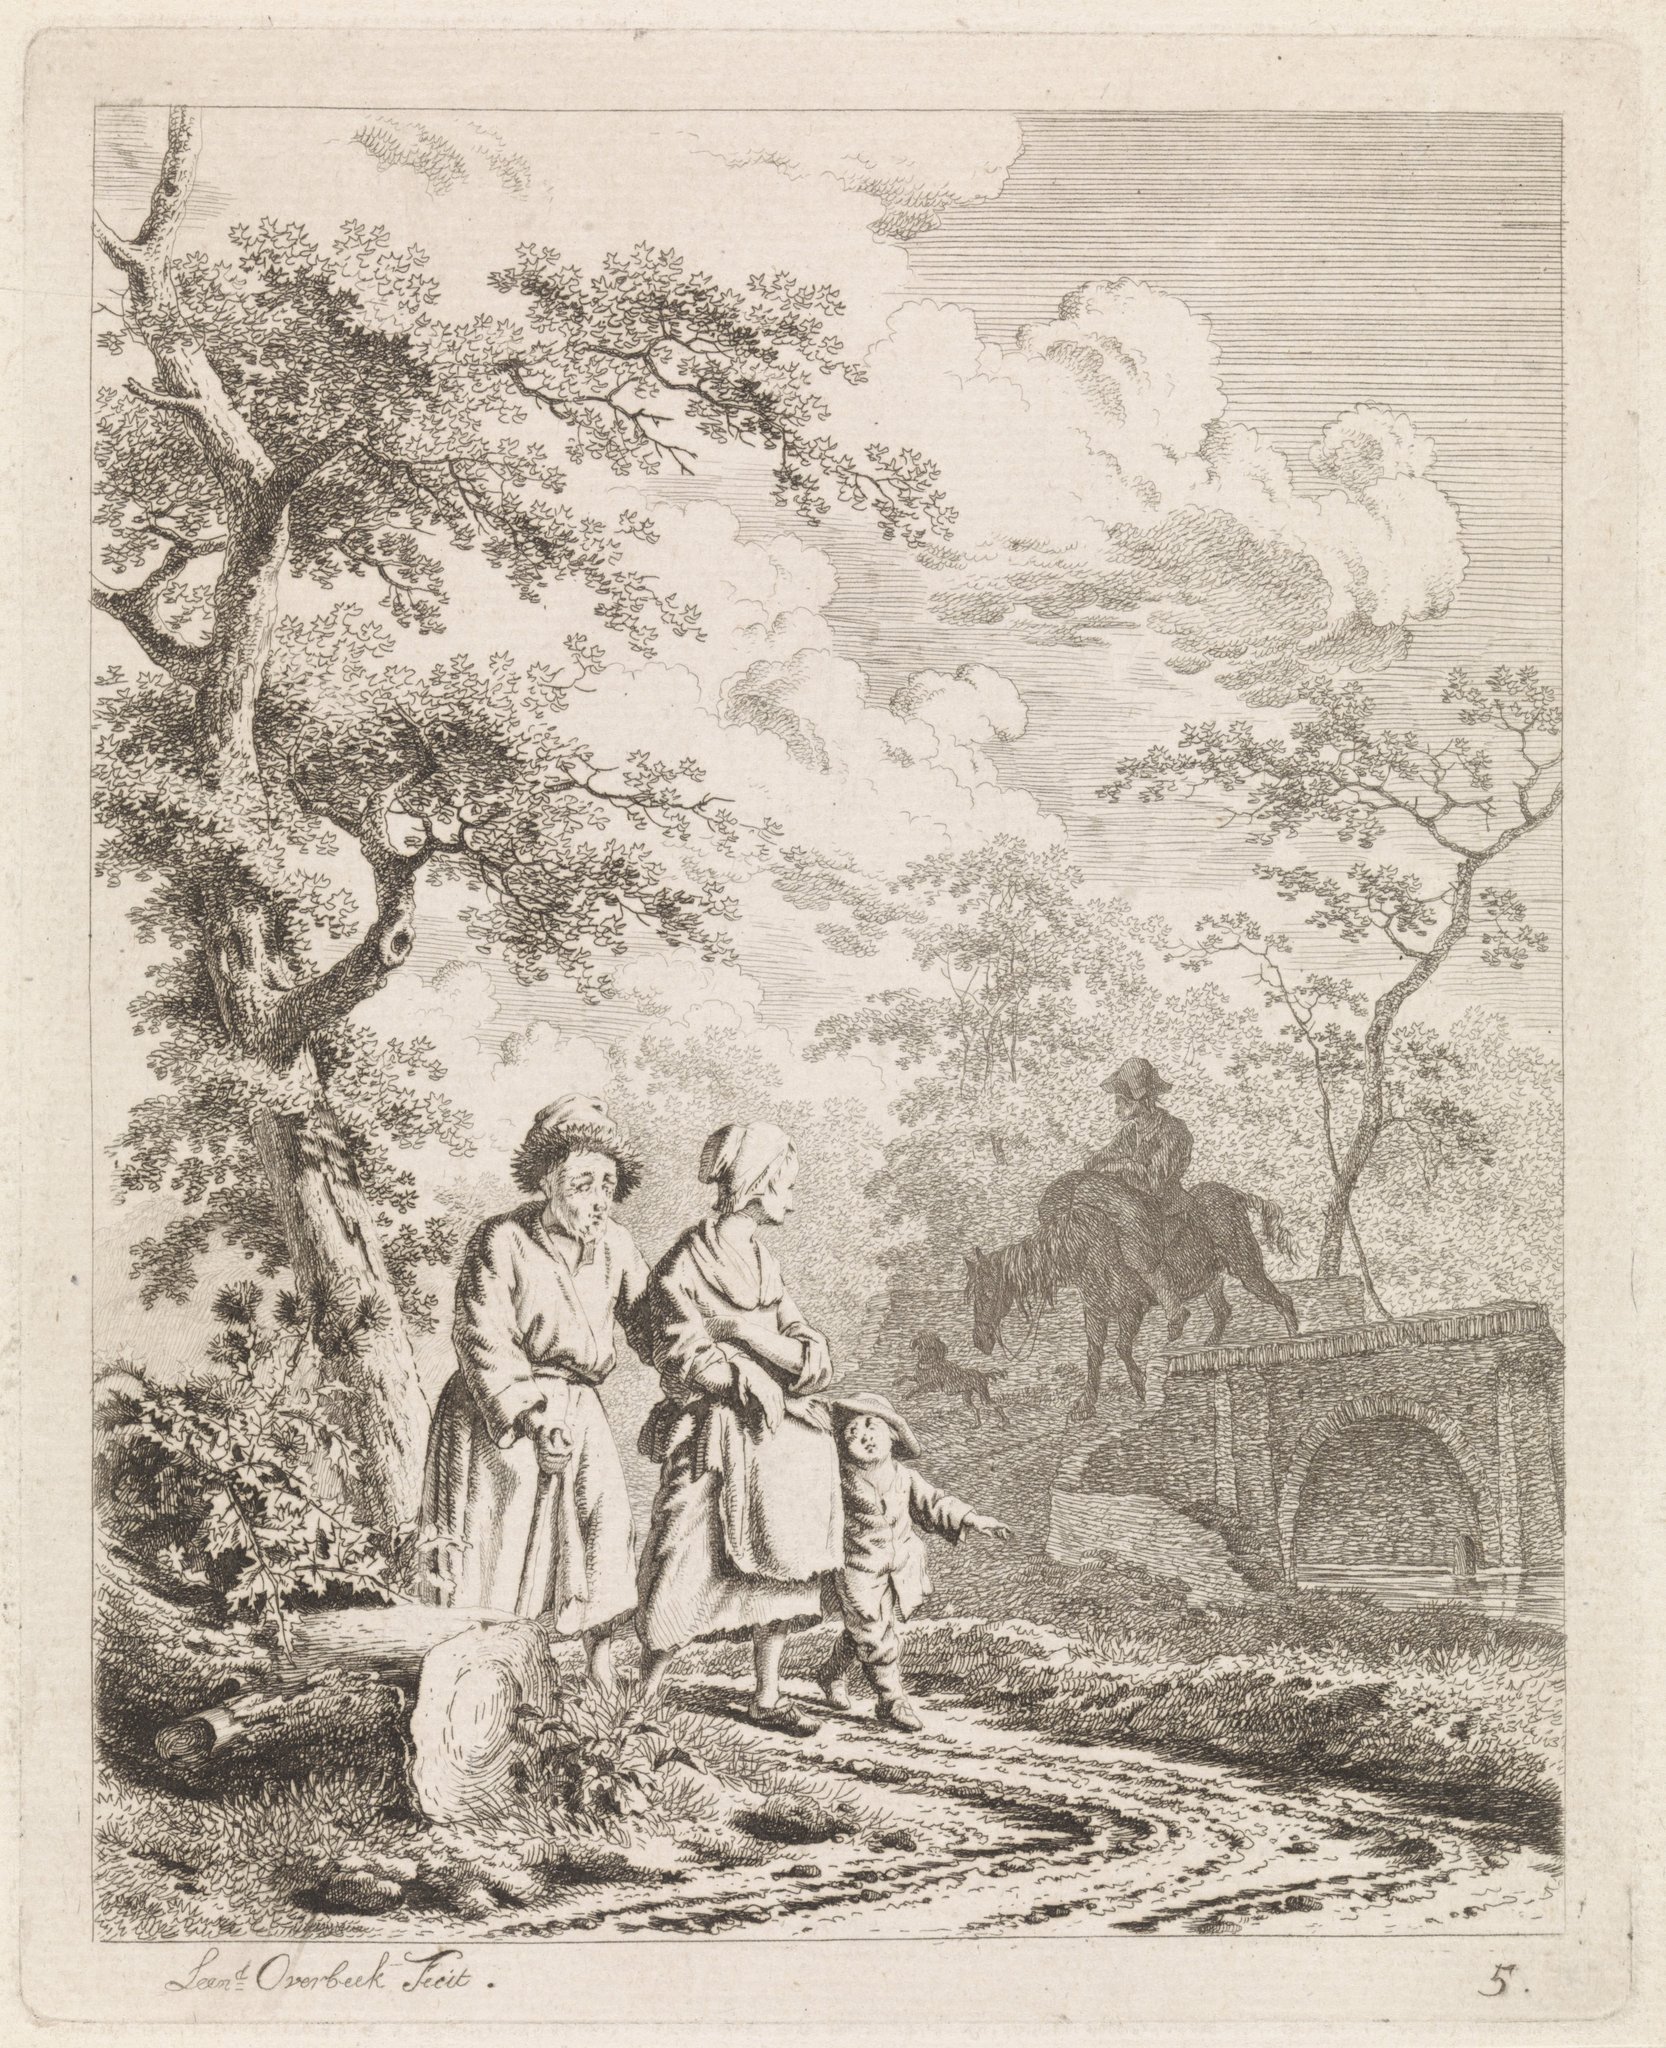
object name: print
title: Grijsaard, vrouw en kind op een bospad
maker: leendert overbeek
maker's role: draughtsman, painter, print maker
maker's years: 1752-1815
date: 1791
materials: paper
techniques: etching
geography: haarlem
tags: young versus old age; young and old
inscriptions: collector's mark: Lugt 2228